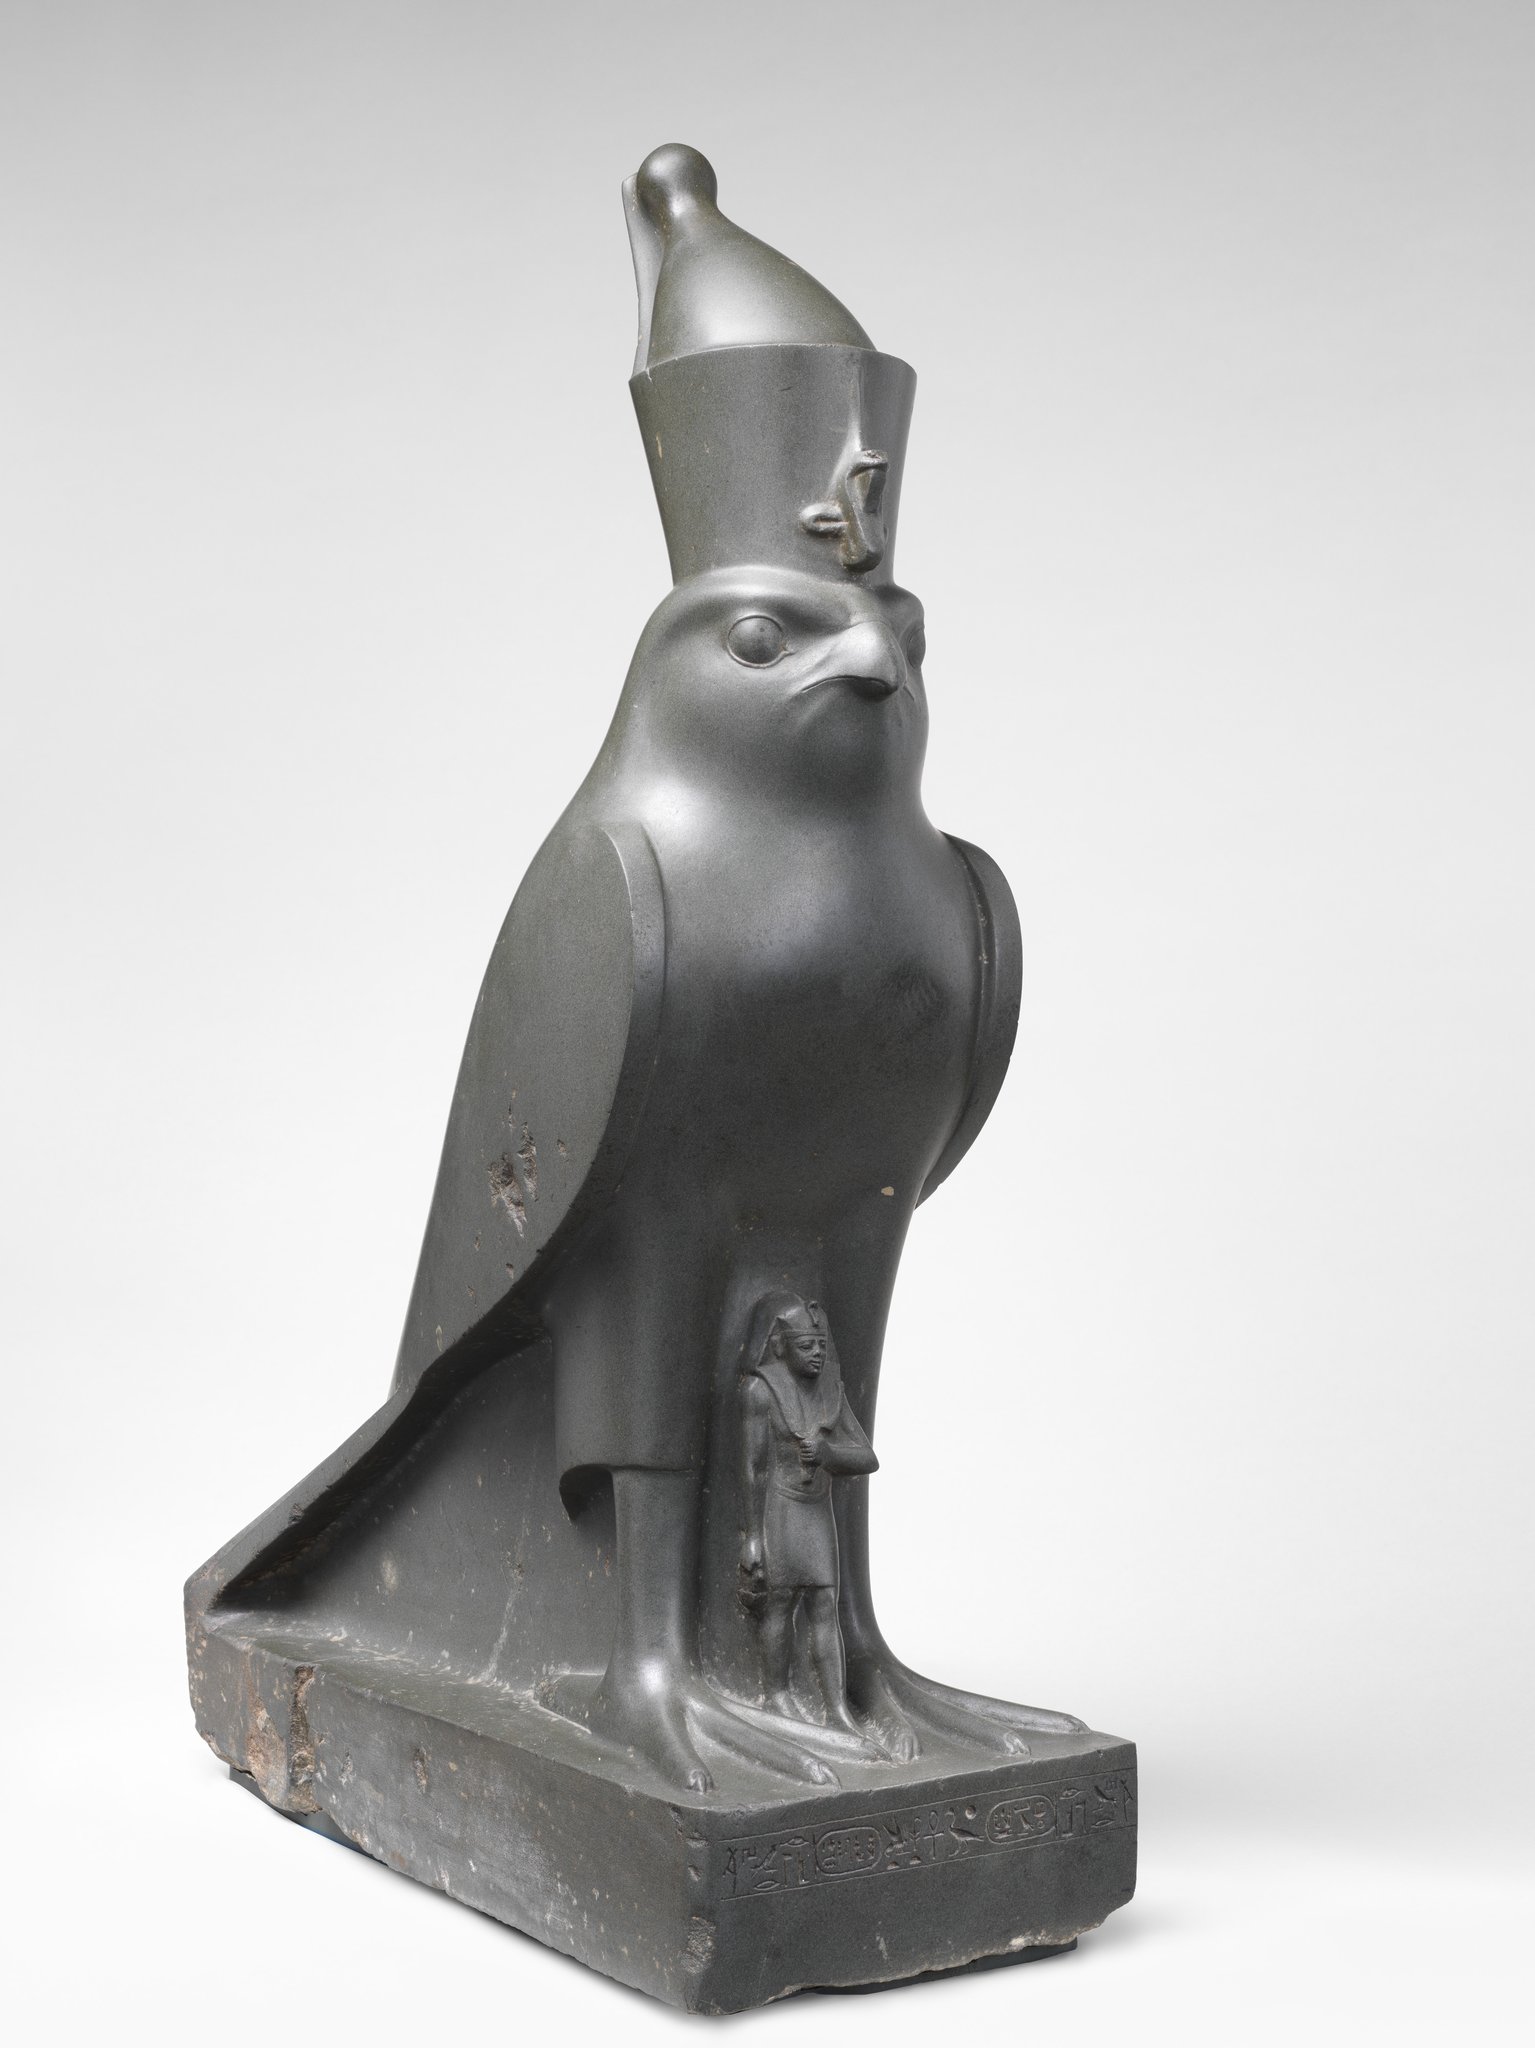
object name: statue, horus, king nectanebo ii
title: Statue of Horus as a falcon protecting King Nectanebo II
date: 360-343 BCE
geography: memphite region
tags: falcons,men,horus,crowns